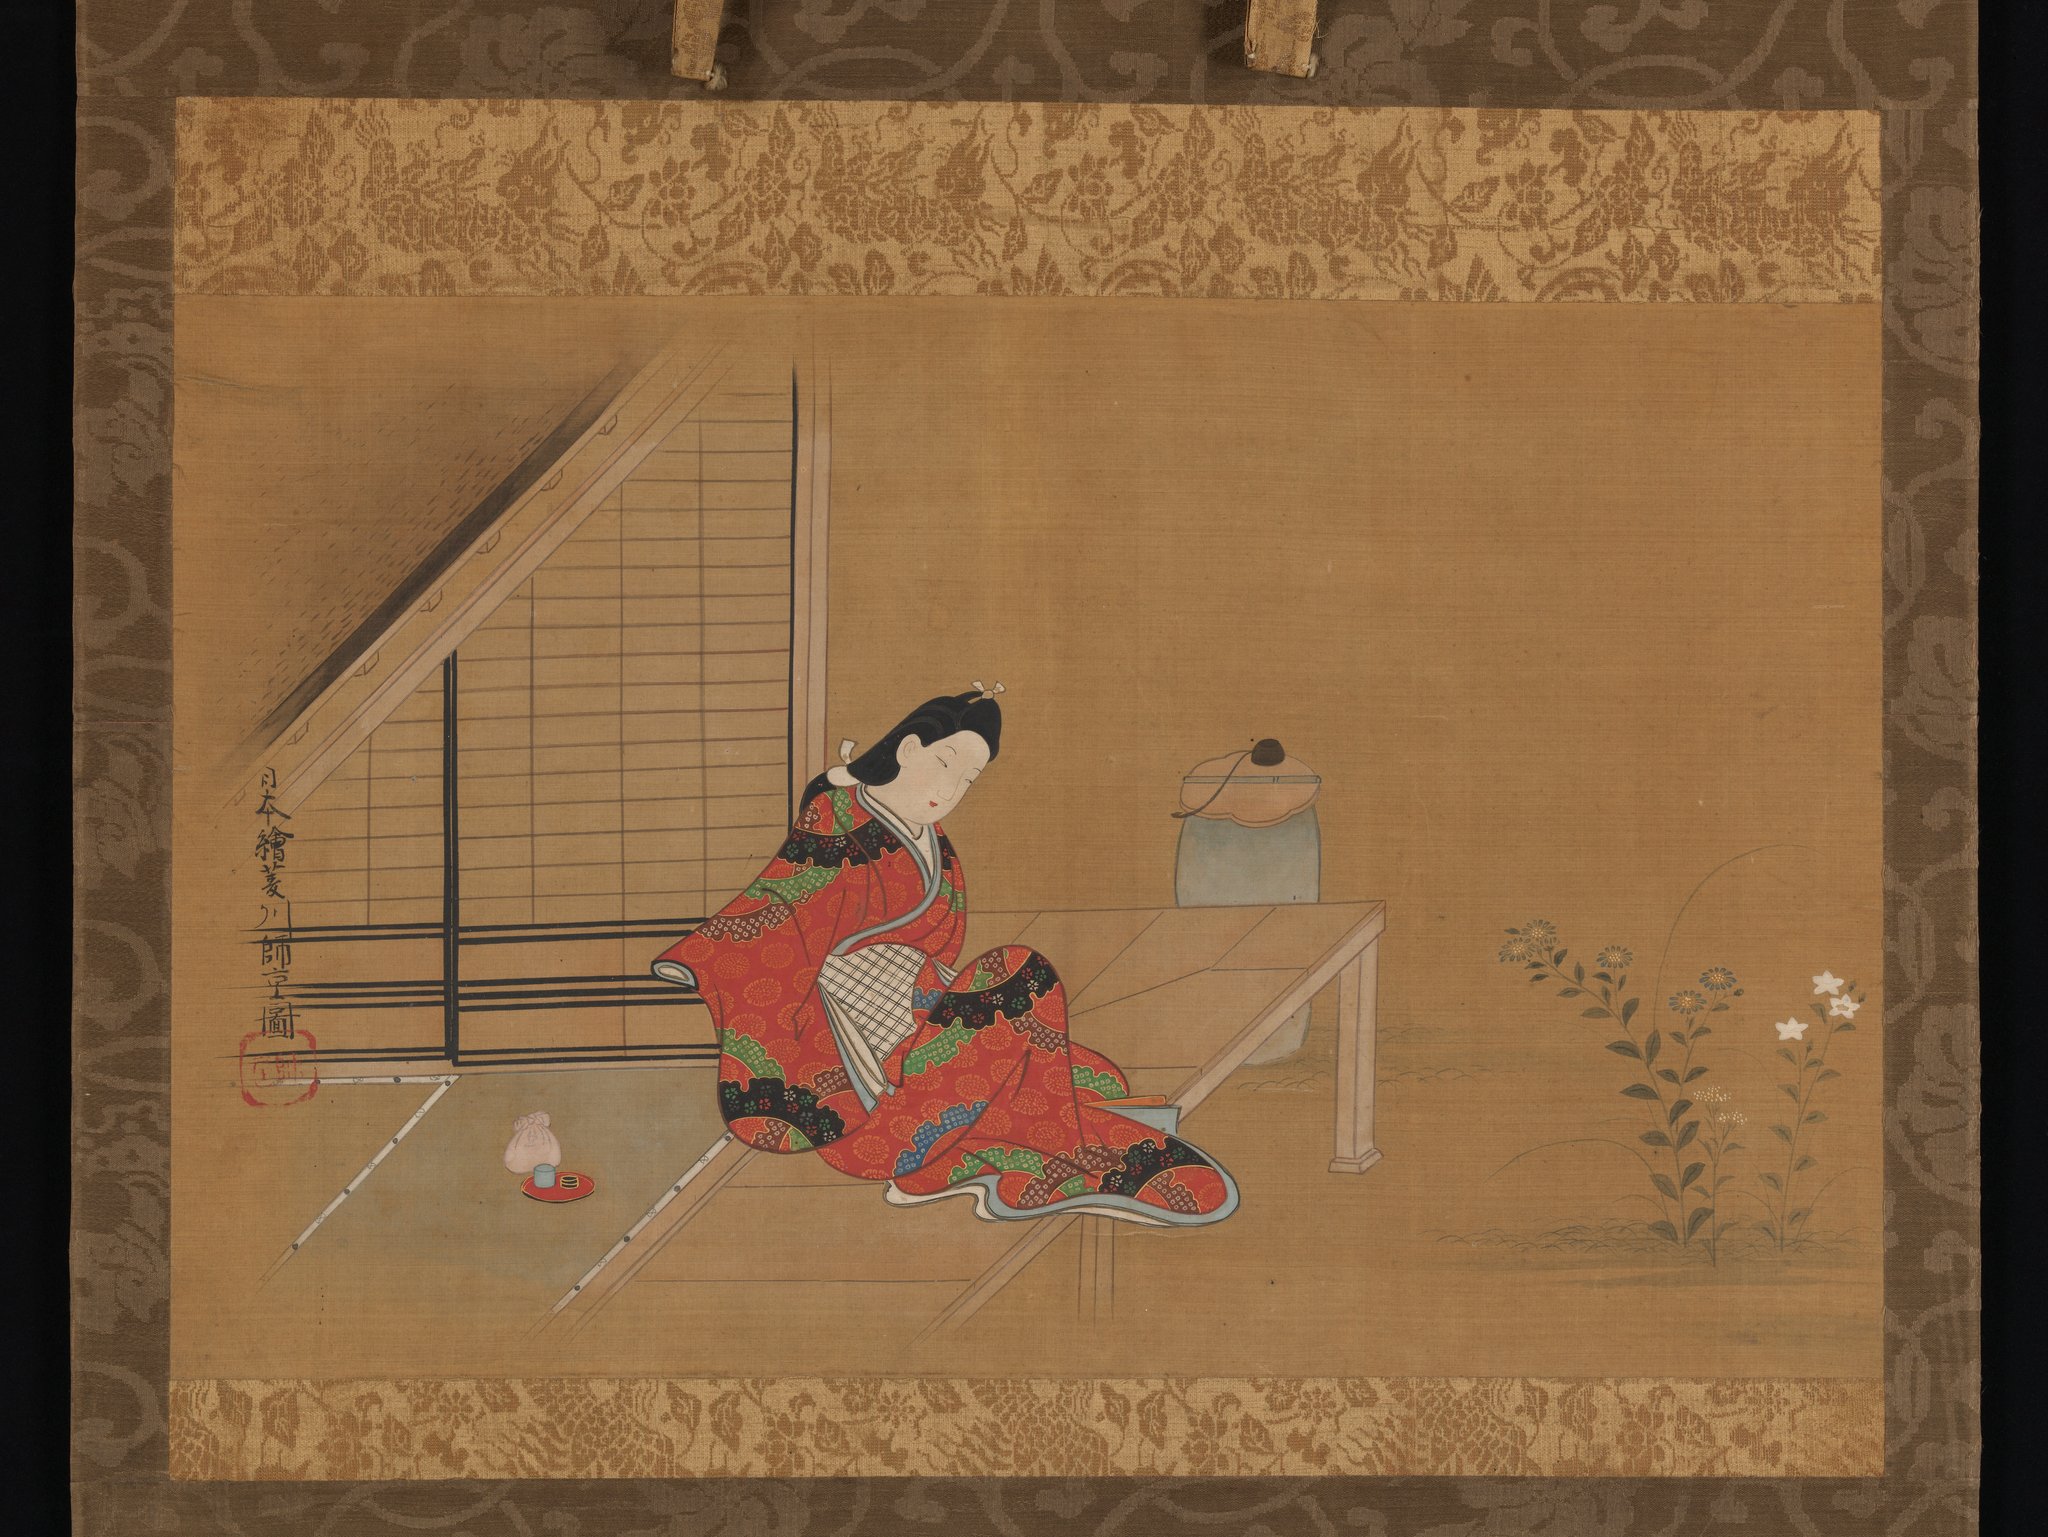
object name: hanging scroll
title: Young Woman on a Veranda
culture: japanese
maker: furuyama moroshige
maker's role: artist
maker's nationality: japanese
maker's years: 1650-1699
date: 1651-1700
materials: ink, silk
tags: women